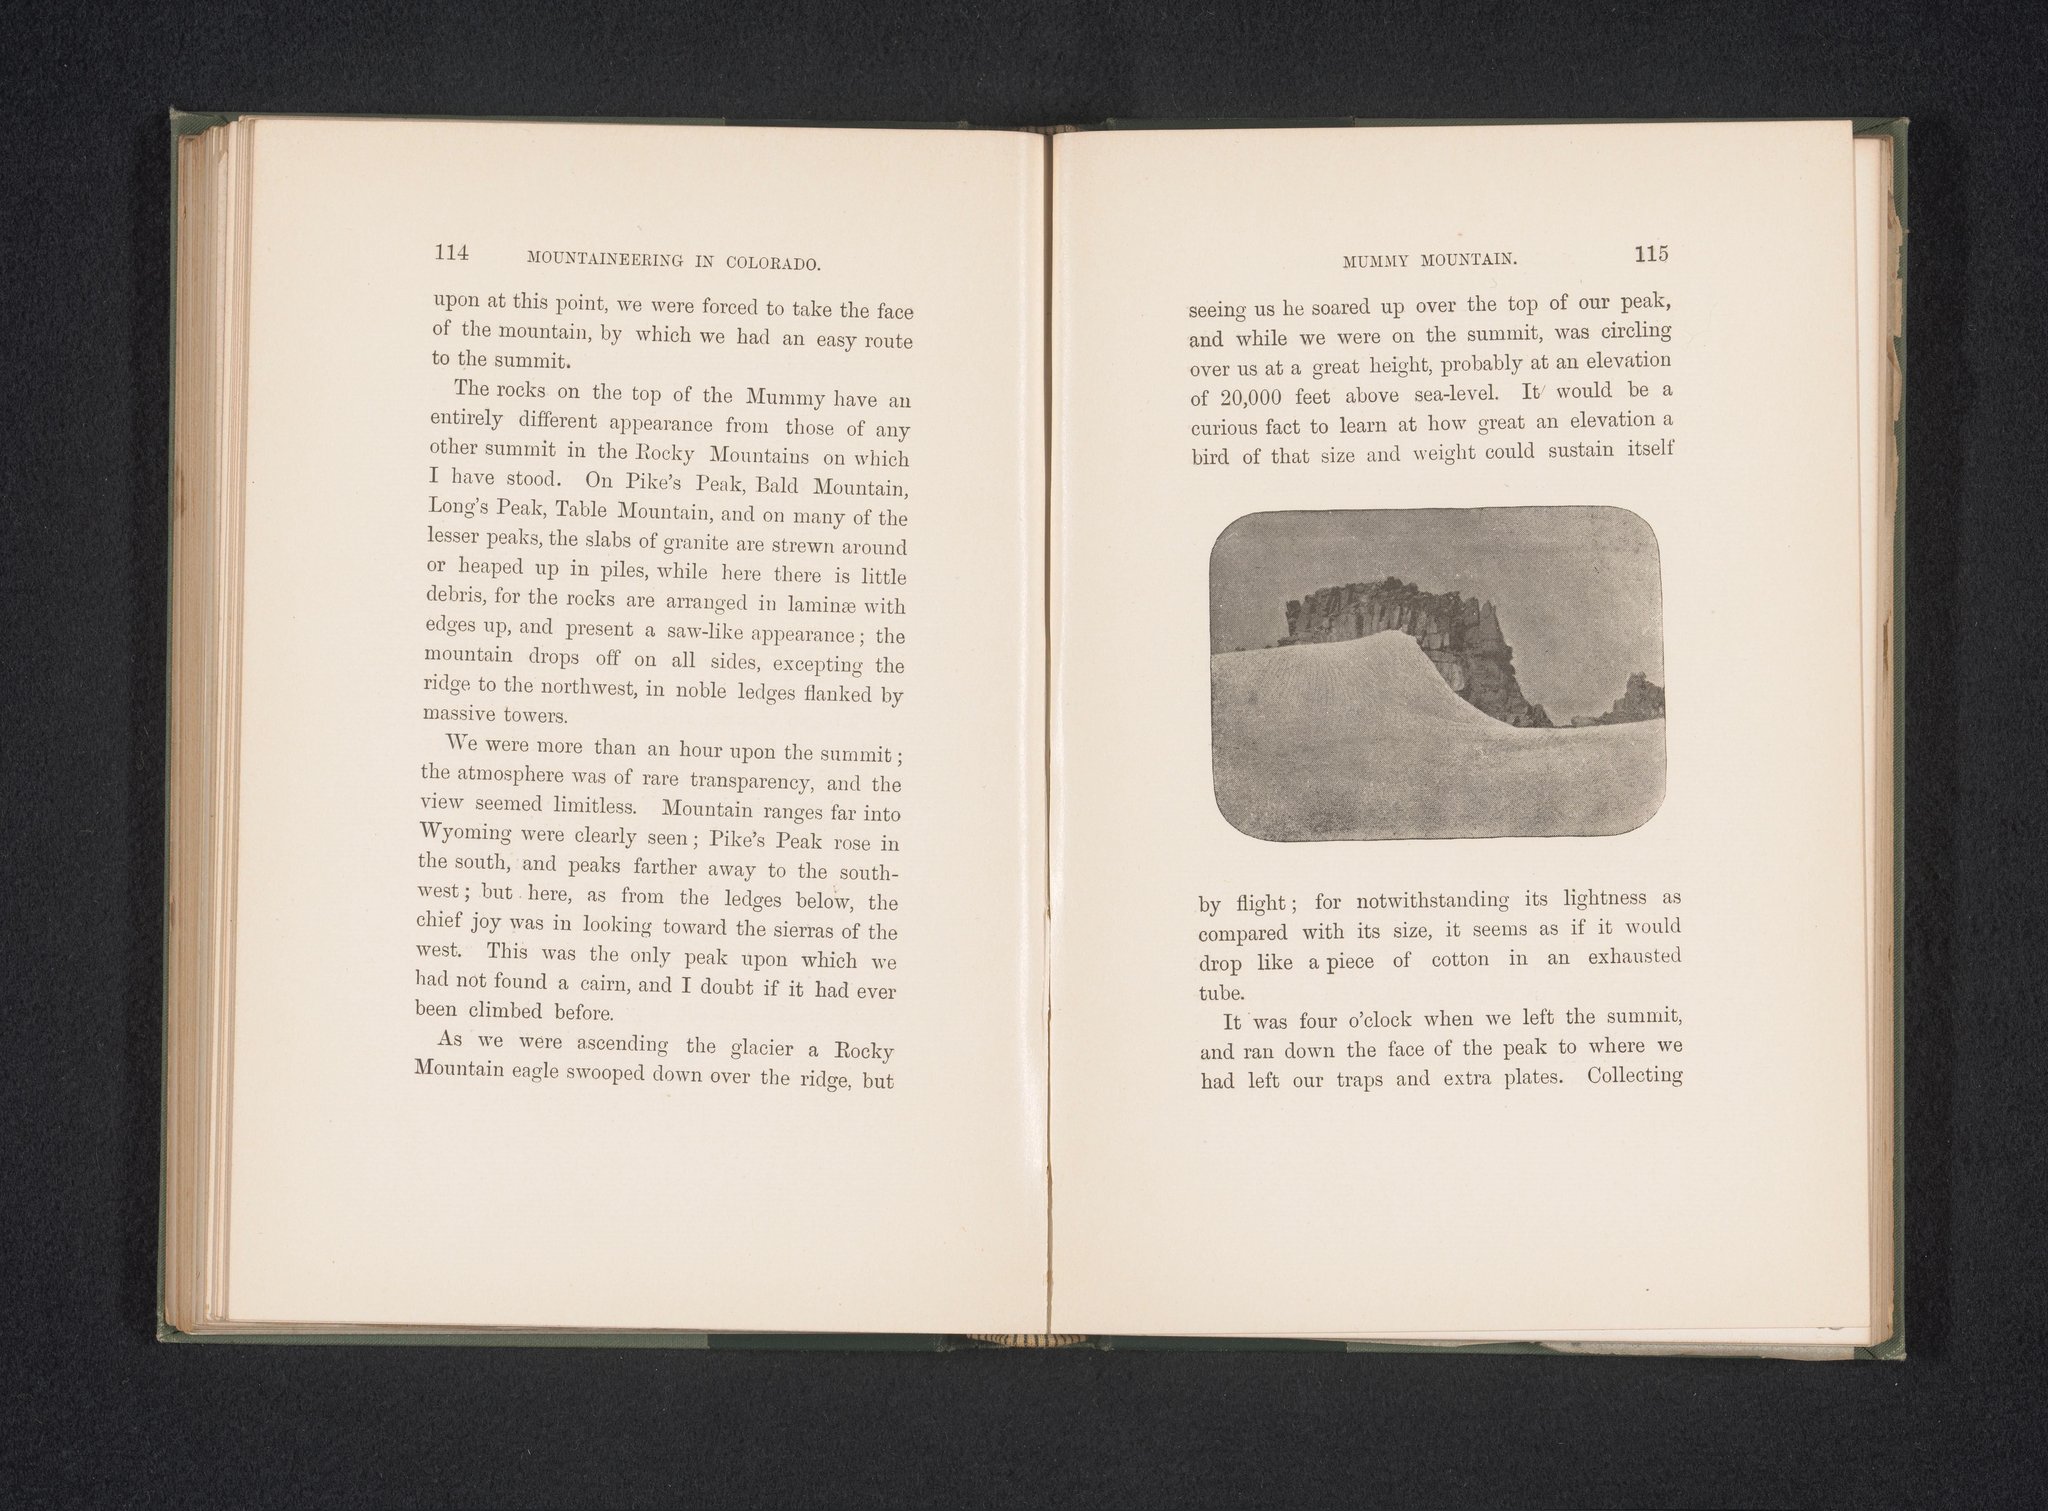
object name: page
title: Gezicht op een gletsjer in het Rocky Mountain National Park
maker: frederick hastings chapin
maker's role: antropoloog, archeoloog, fotograaf, schrijver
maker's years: 1852-1900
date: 1885-1890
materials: paper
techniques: autotype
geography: boston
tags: landscapes, glacier